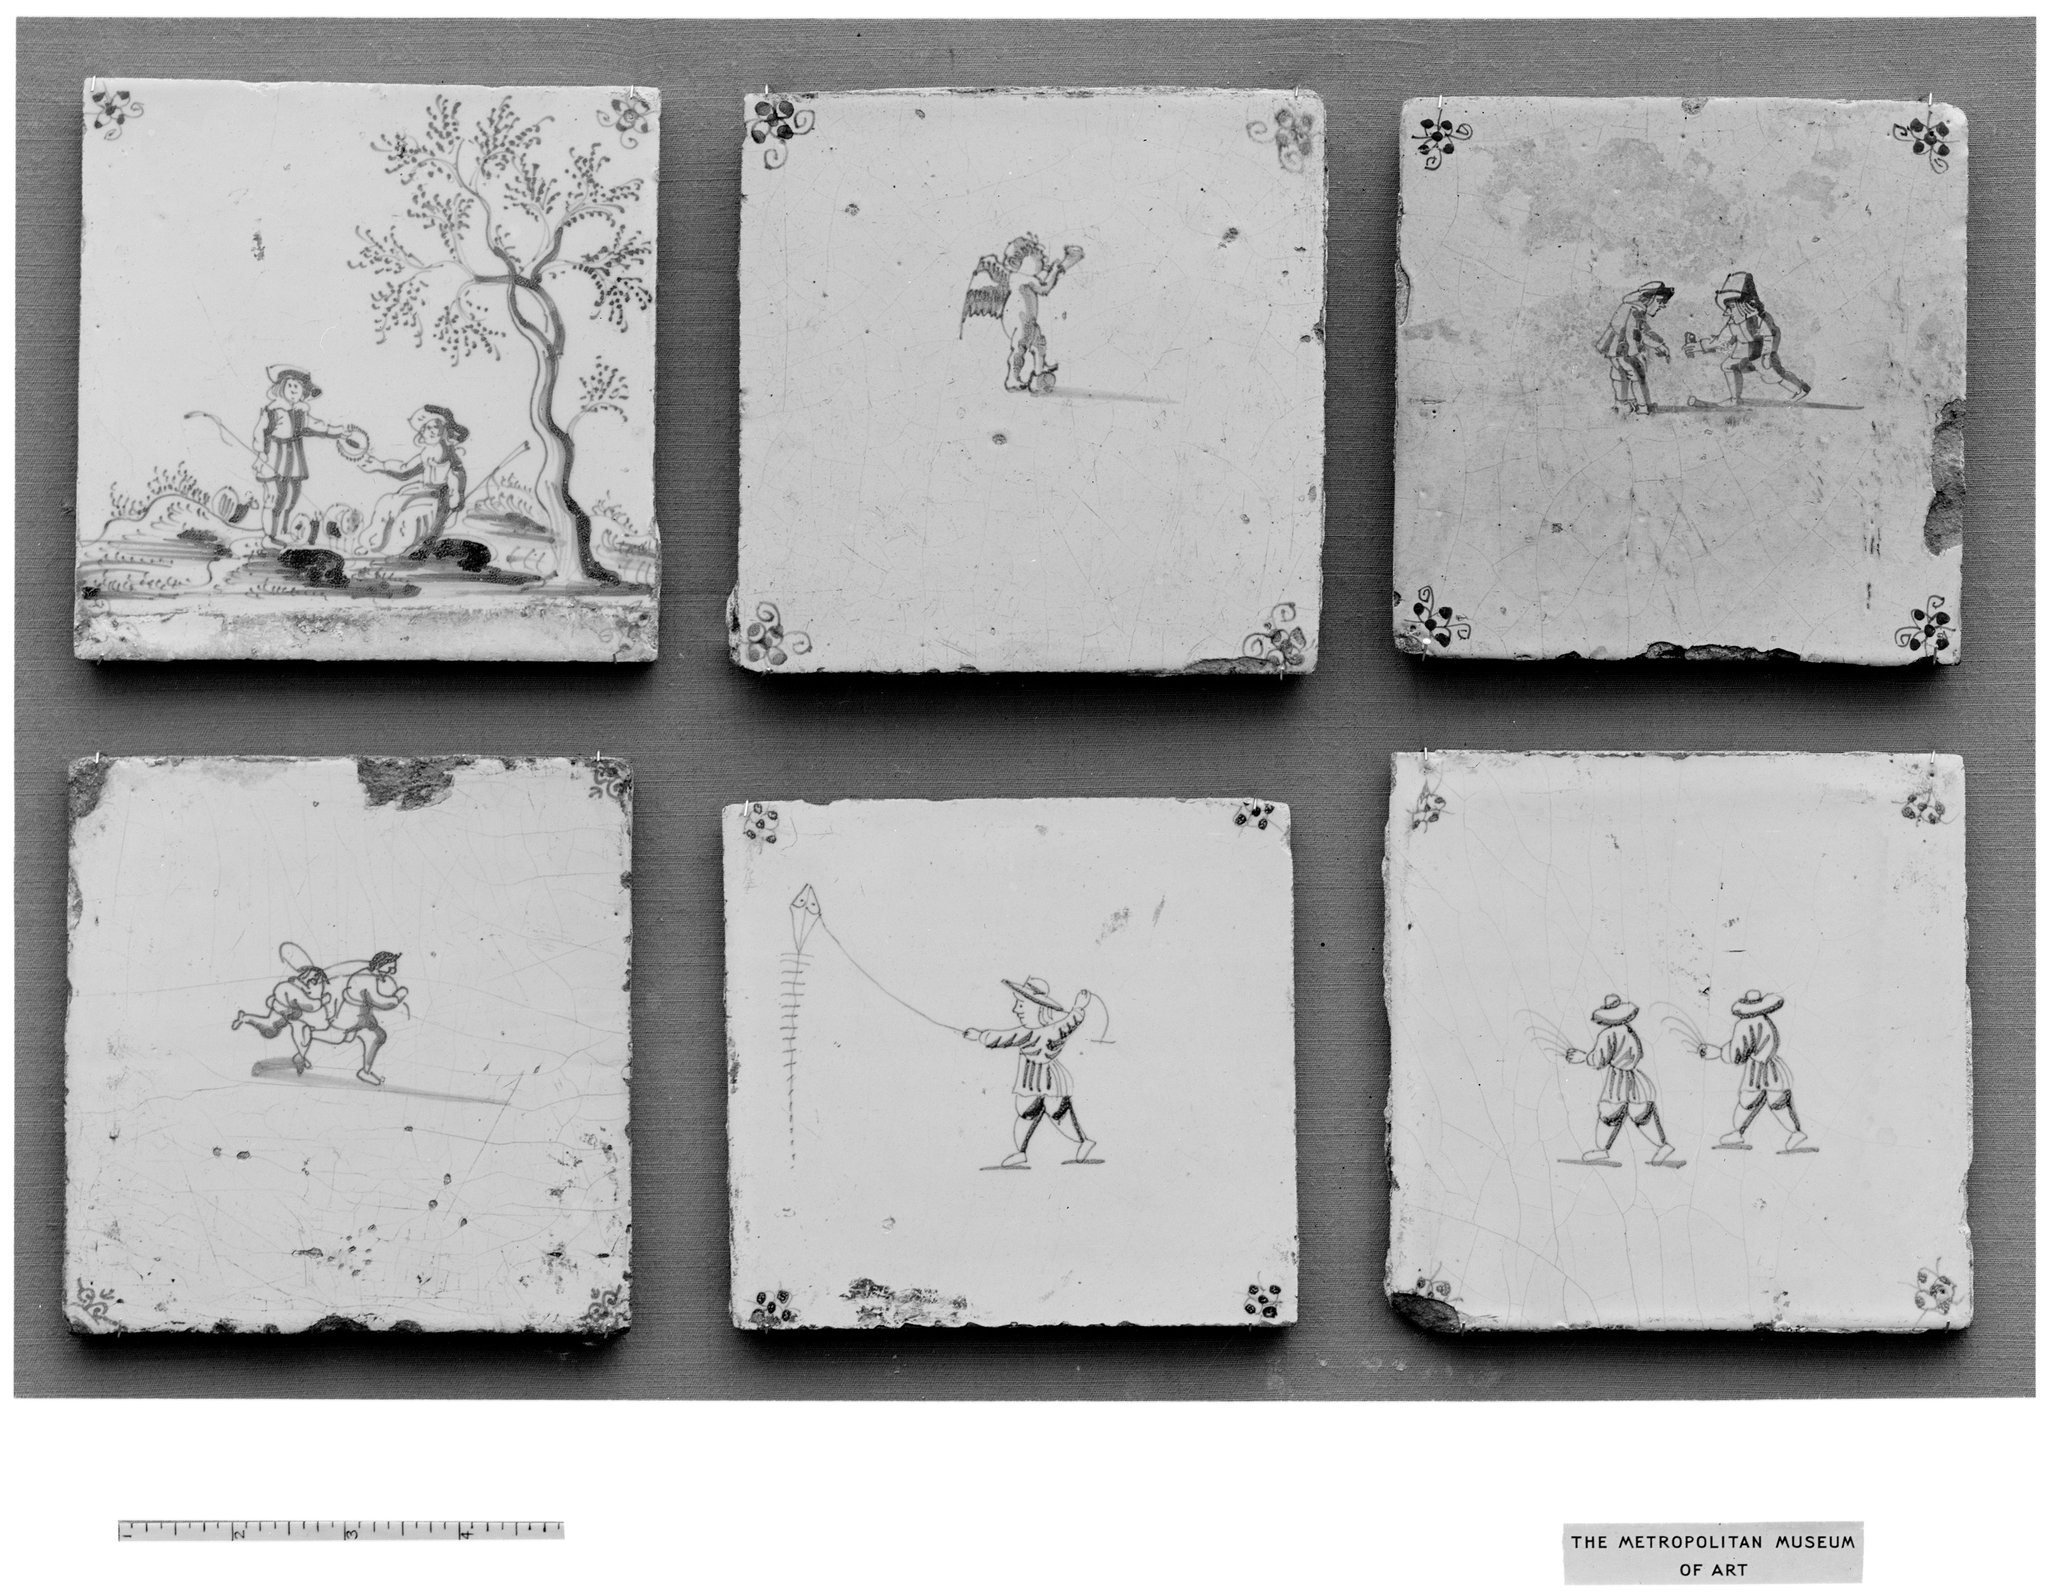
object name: tile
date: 1701-1800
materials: earthenware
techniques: glazing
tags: boys,men,women,trees